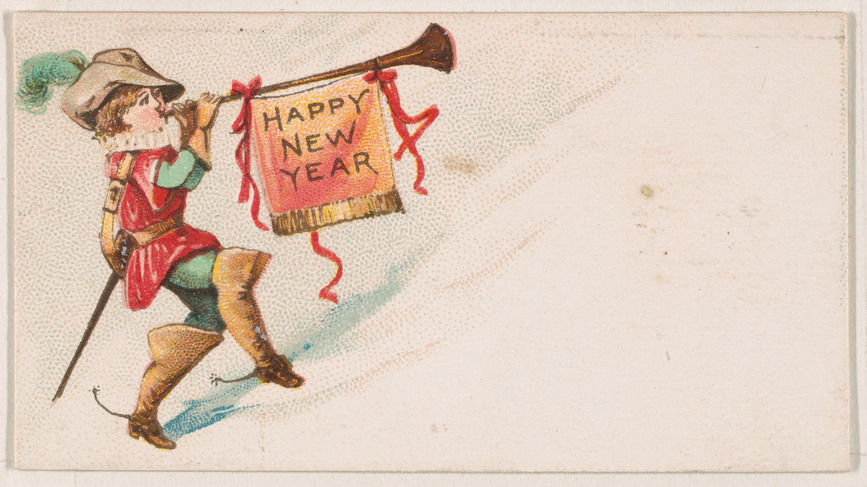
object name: print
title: Happy New Year, from the New Years 1890 series (N227) issued by Kinney Bros.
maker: kinney brothers tobacco company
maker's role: publisher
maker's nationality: american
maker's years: 1869-2011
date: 1889-1890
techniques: color lithograph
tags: musical instruments,boys